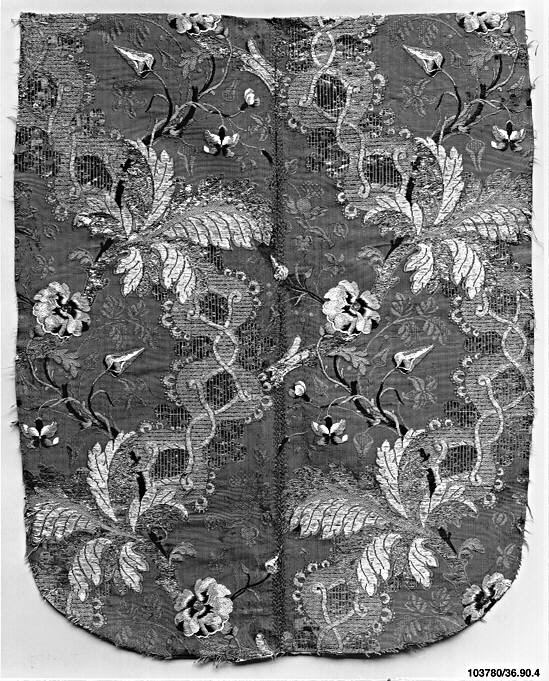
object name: piece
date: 1750-1760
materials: metal thread, silk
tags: flowers,leaves